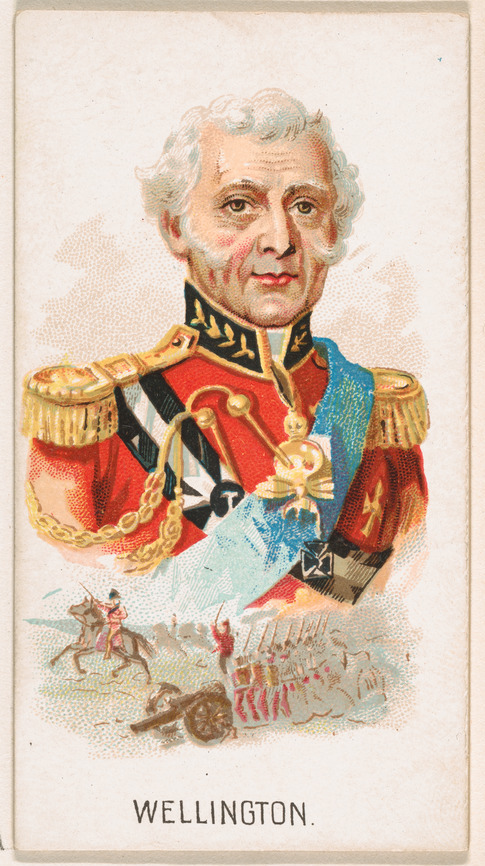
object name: print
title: Wellington, from Leaders series (N222) issued by Kinney Bros.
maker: kinney brothers tobacco company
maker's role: publisher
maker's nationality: american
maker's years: 1869-2011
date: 1888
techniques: color lithograph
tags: men